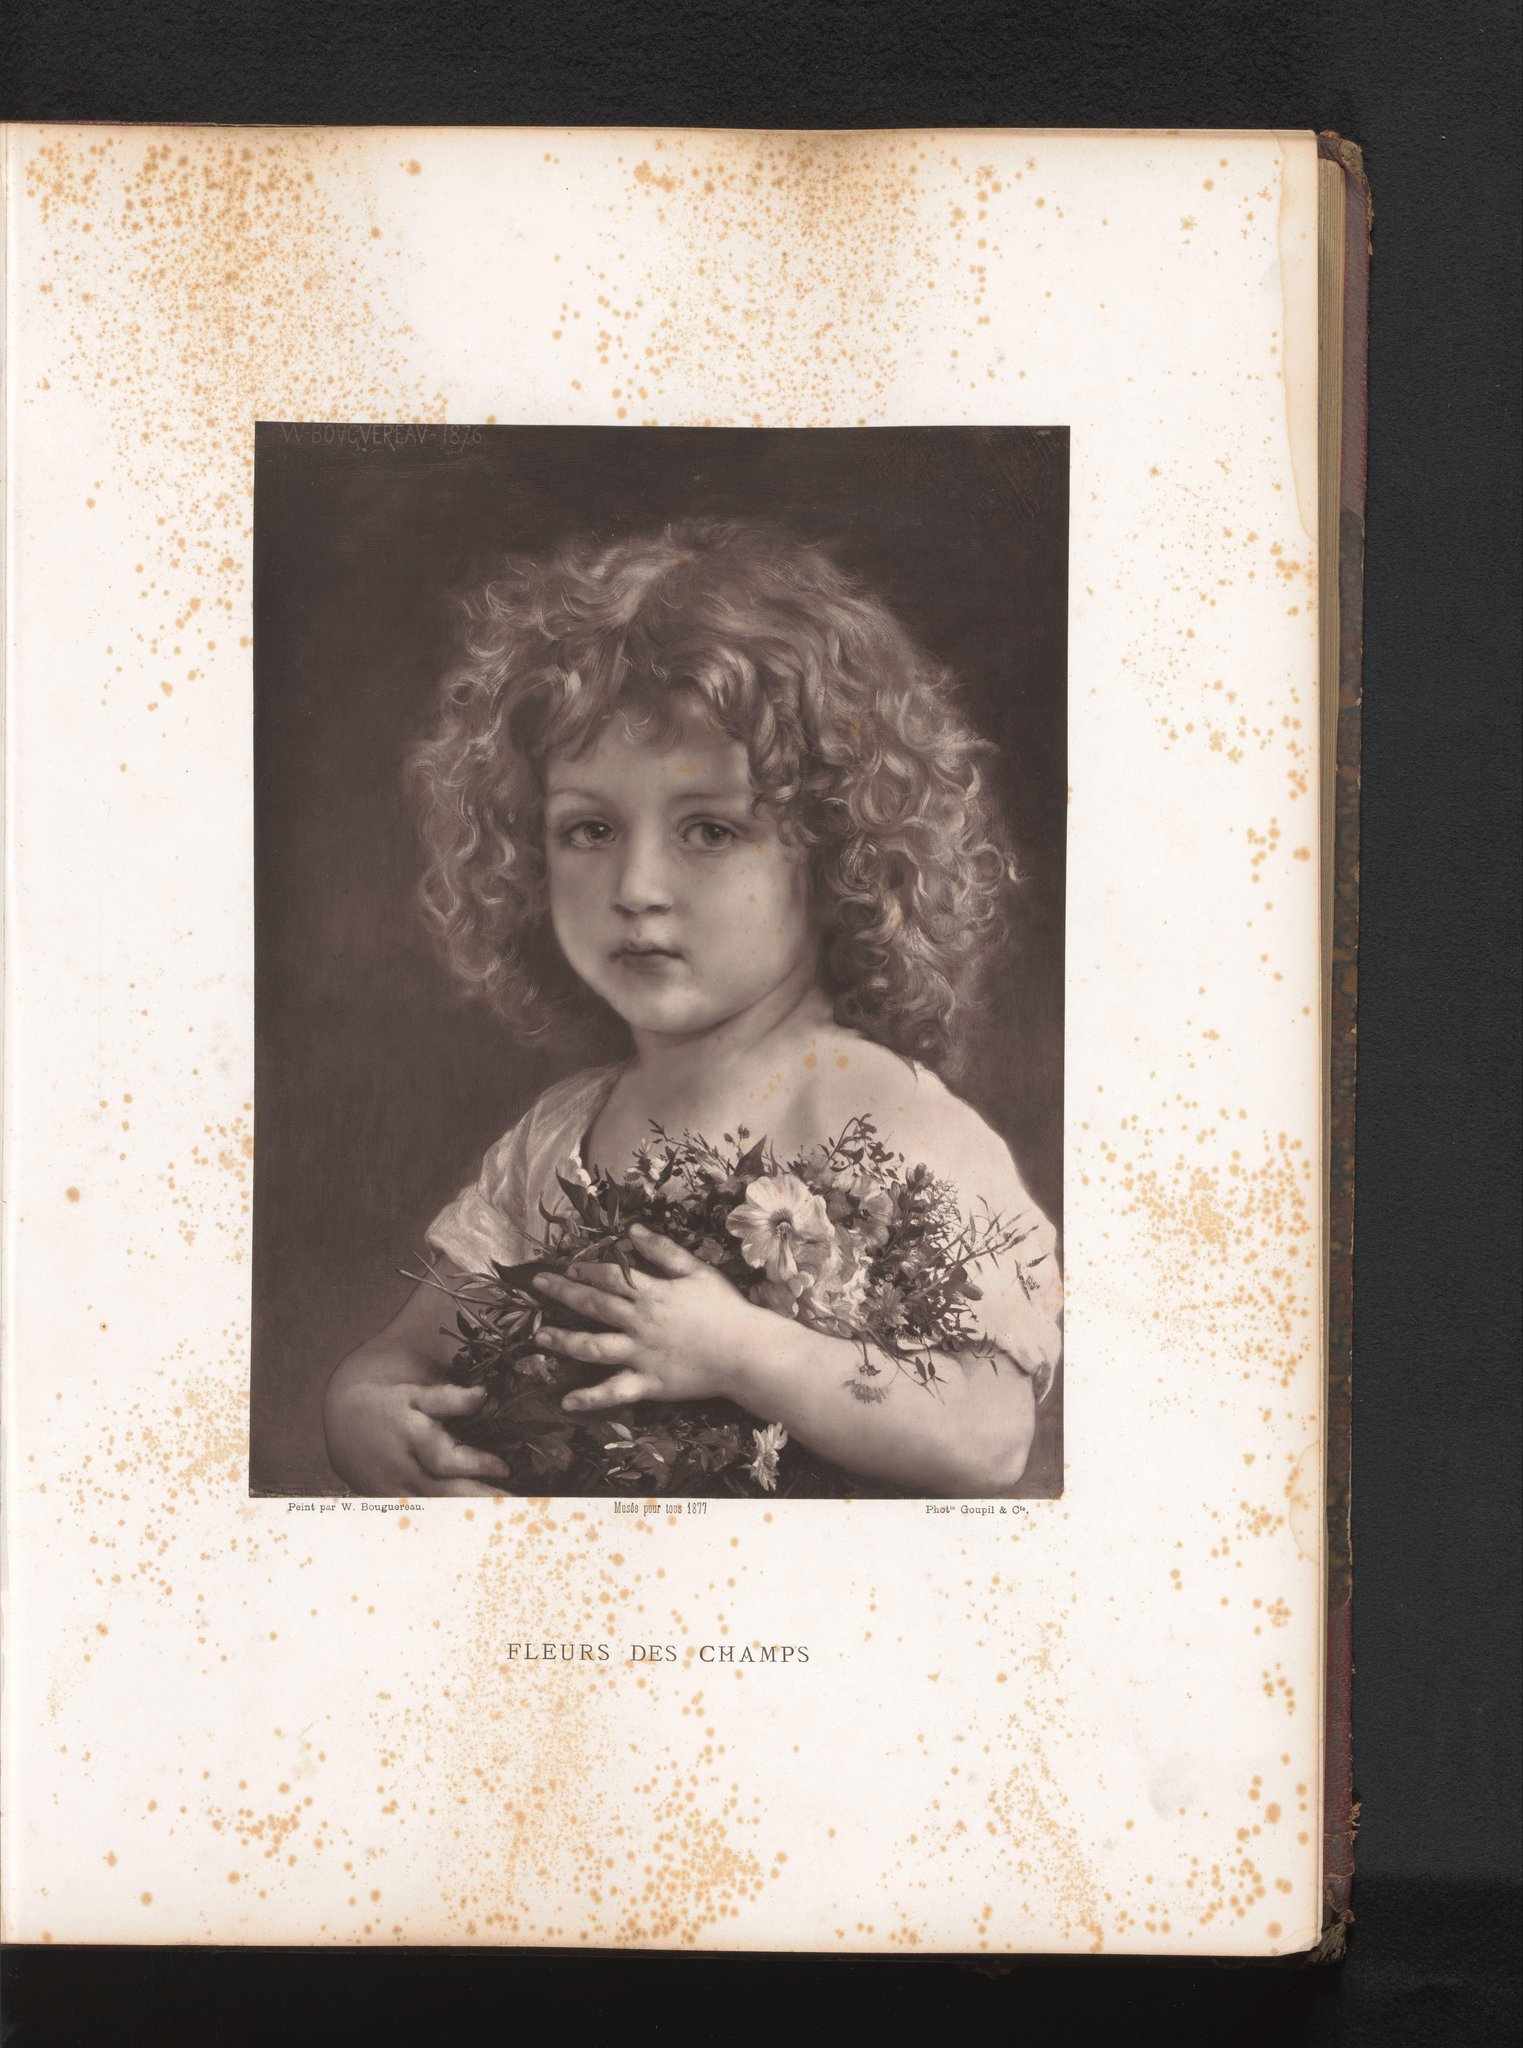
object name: page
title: Reproductie van een schilderij van een meisje met bloemen door William Adolphe Bouguereau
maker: william-adolphe bouguereau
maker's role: draughtsman, painter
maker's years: 1825-1905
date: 1872-1879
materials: paper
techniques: woodburytype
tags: cut flowers; nosegay, bunch of flowers, girl (child between toddler and youth)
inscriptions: inscription: ‘Musée pour tous 1877’